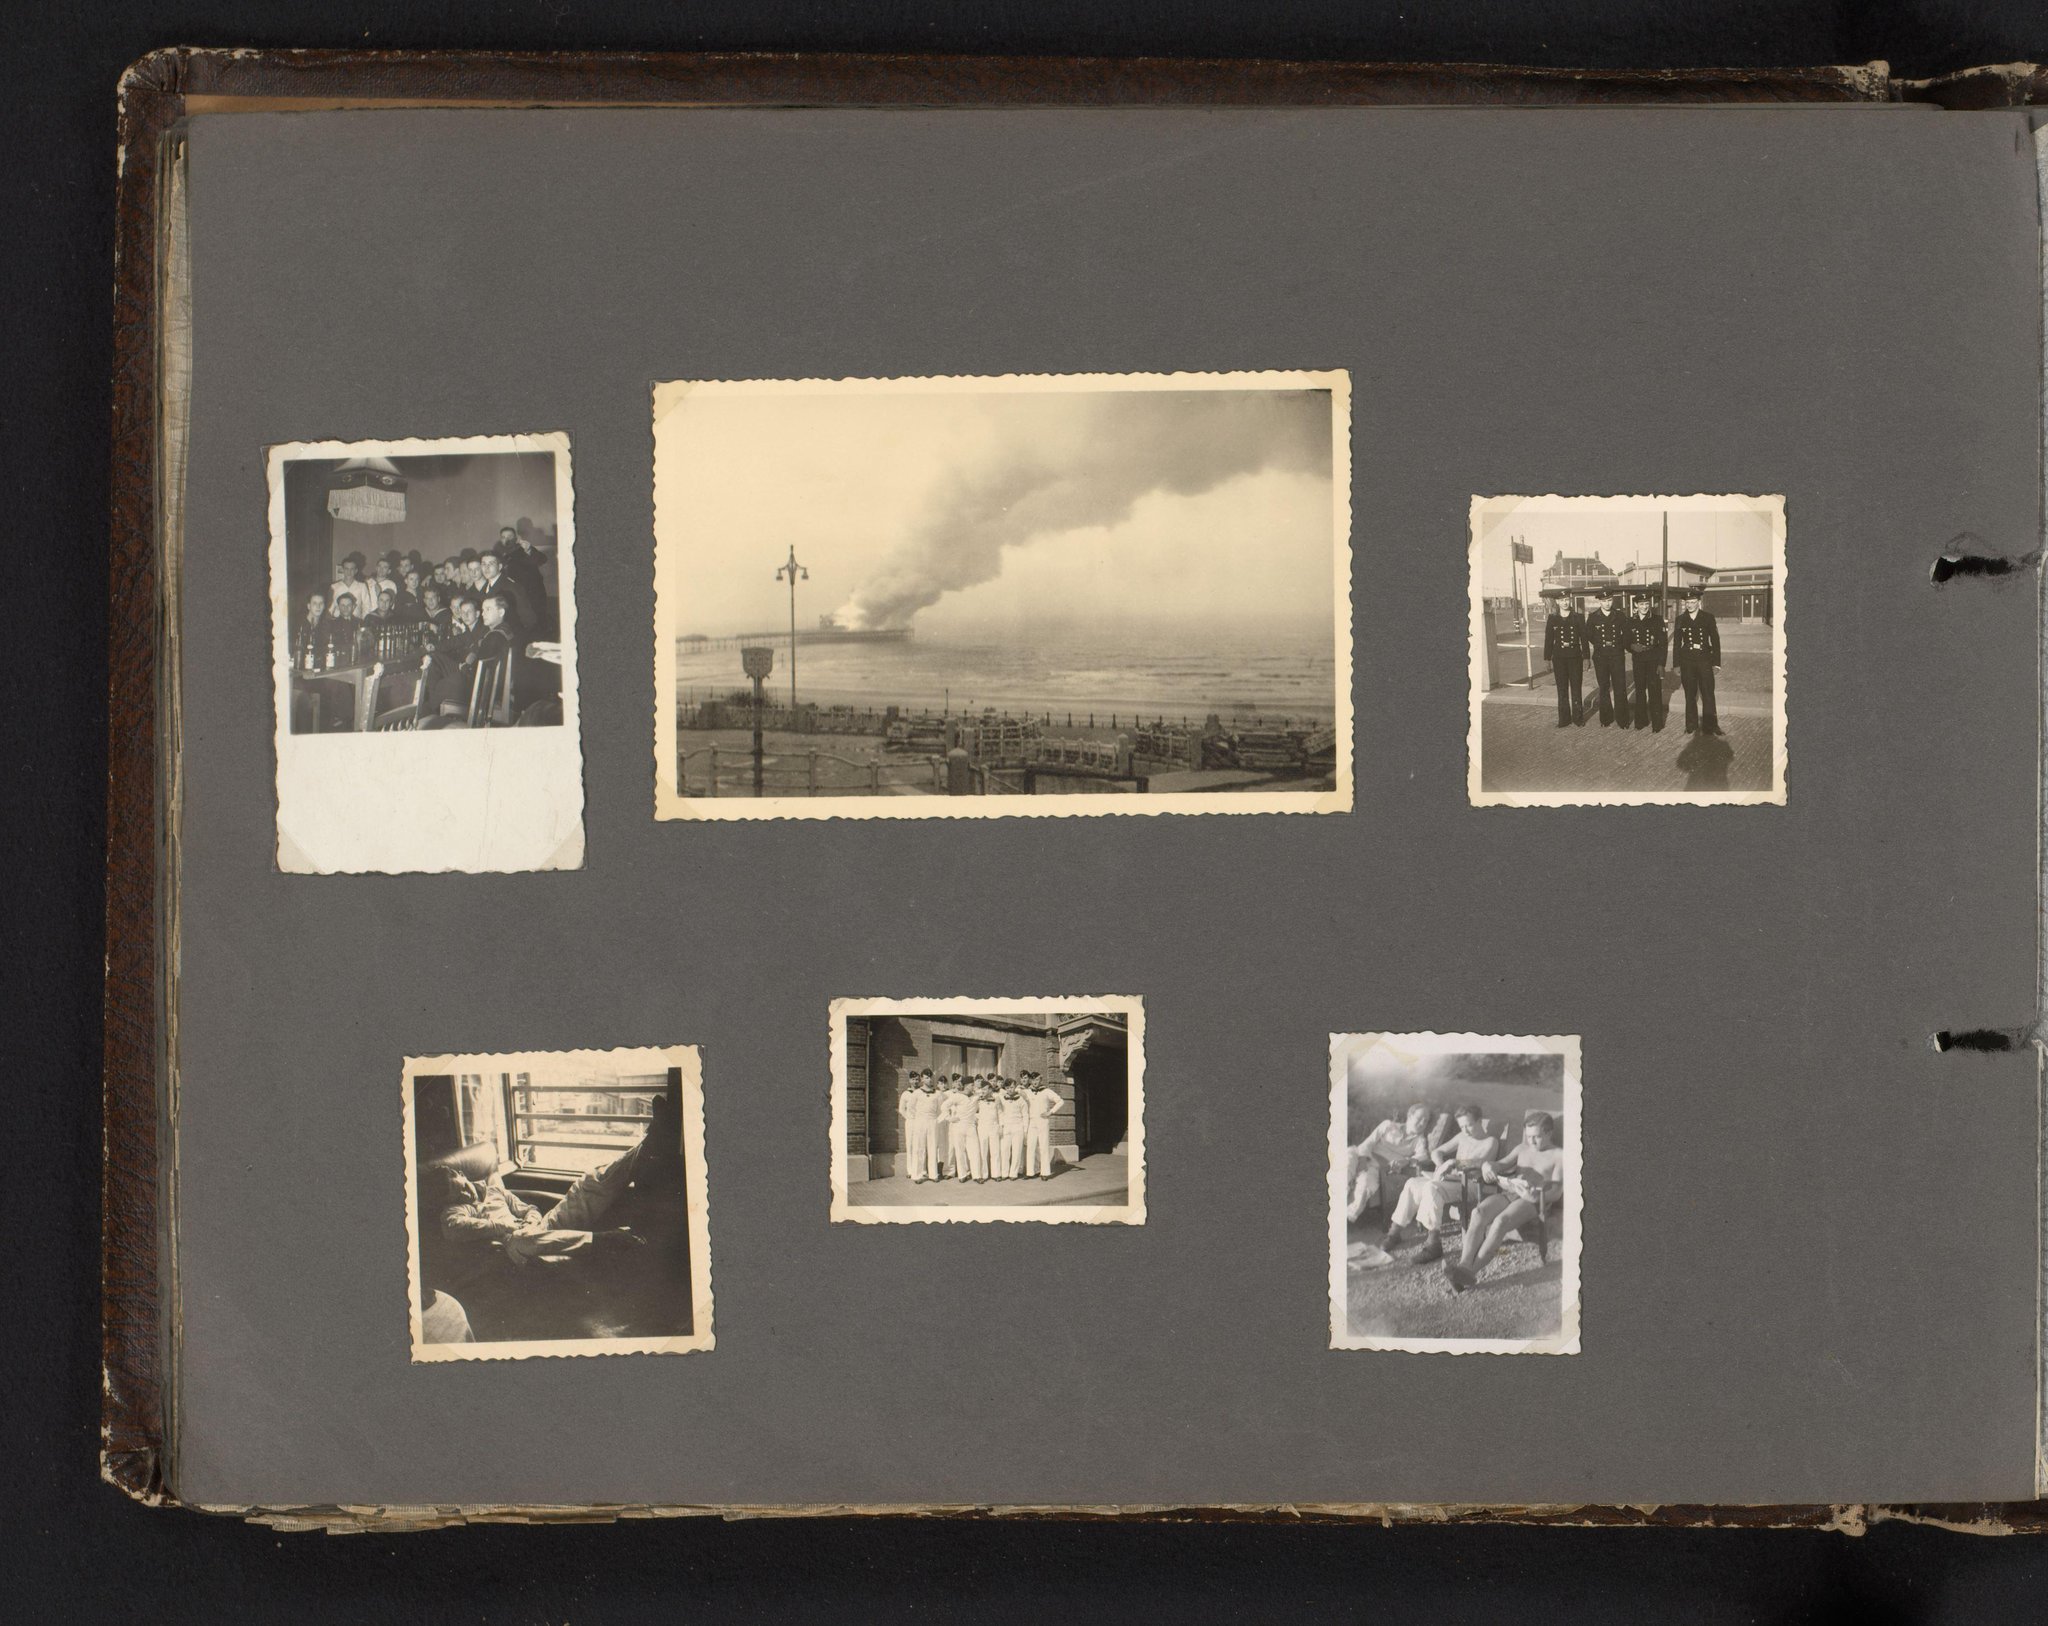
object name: photograph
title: Brand Scheveningse pier 1943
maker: Anonymous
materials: paper, photographic support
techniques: gelatin silver print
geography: scheveningen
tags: on fire, ablaze, the company, the unit, the troop ~ military service, sailor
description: Albumblad met een foto van de brand in de Scheveningse pier op 26 maart 1943 en foto's van andere matrozen van de Kriegsmarine. Onderdeel van het fotoalbum Kriegsmarine.